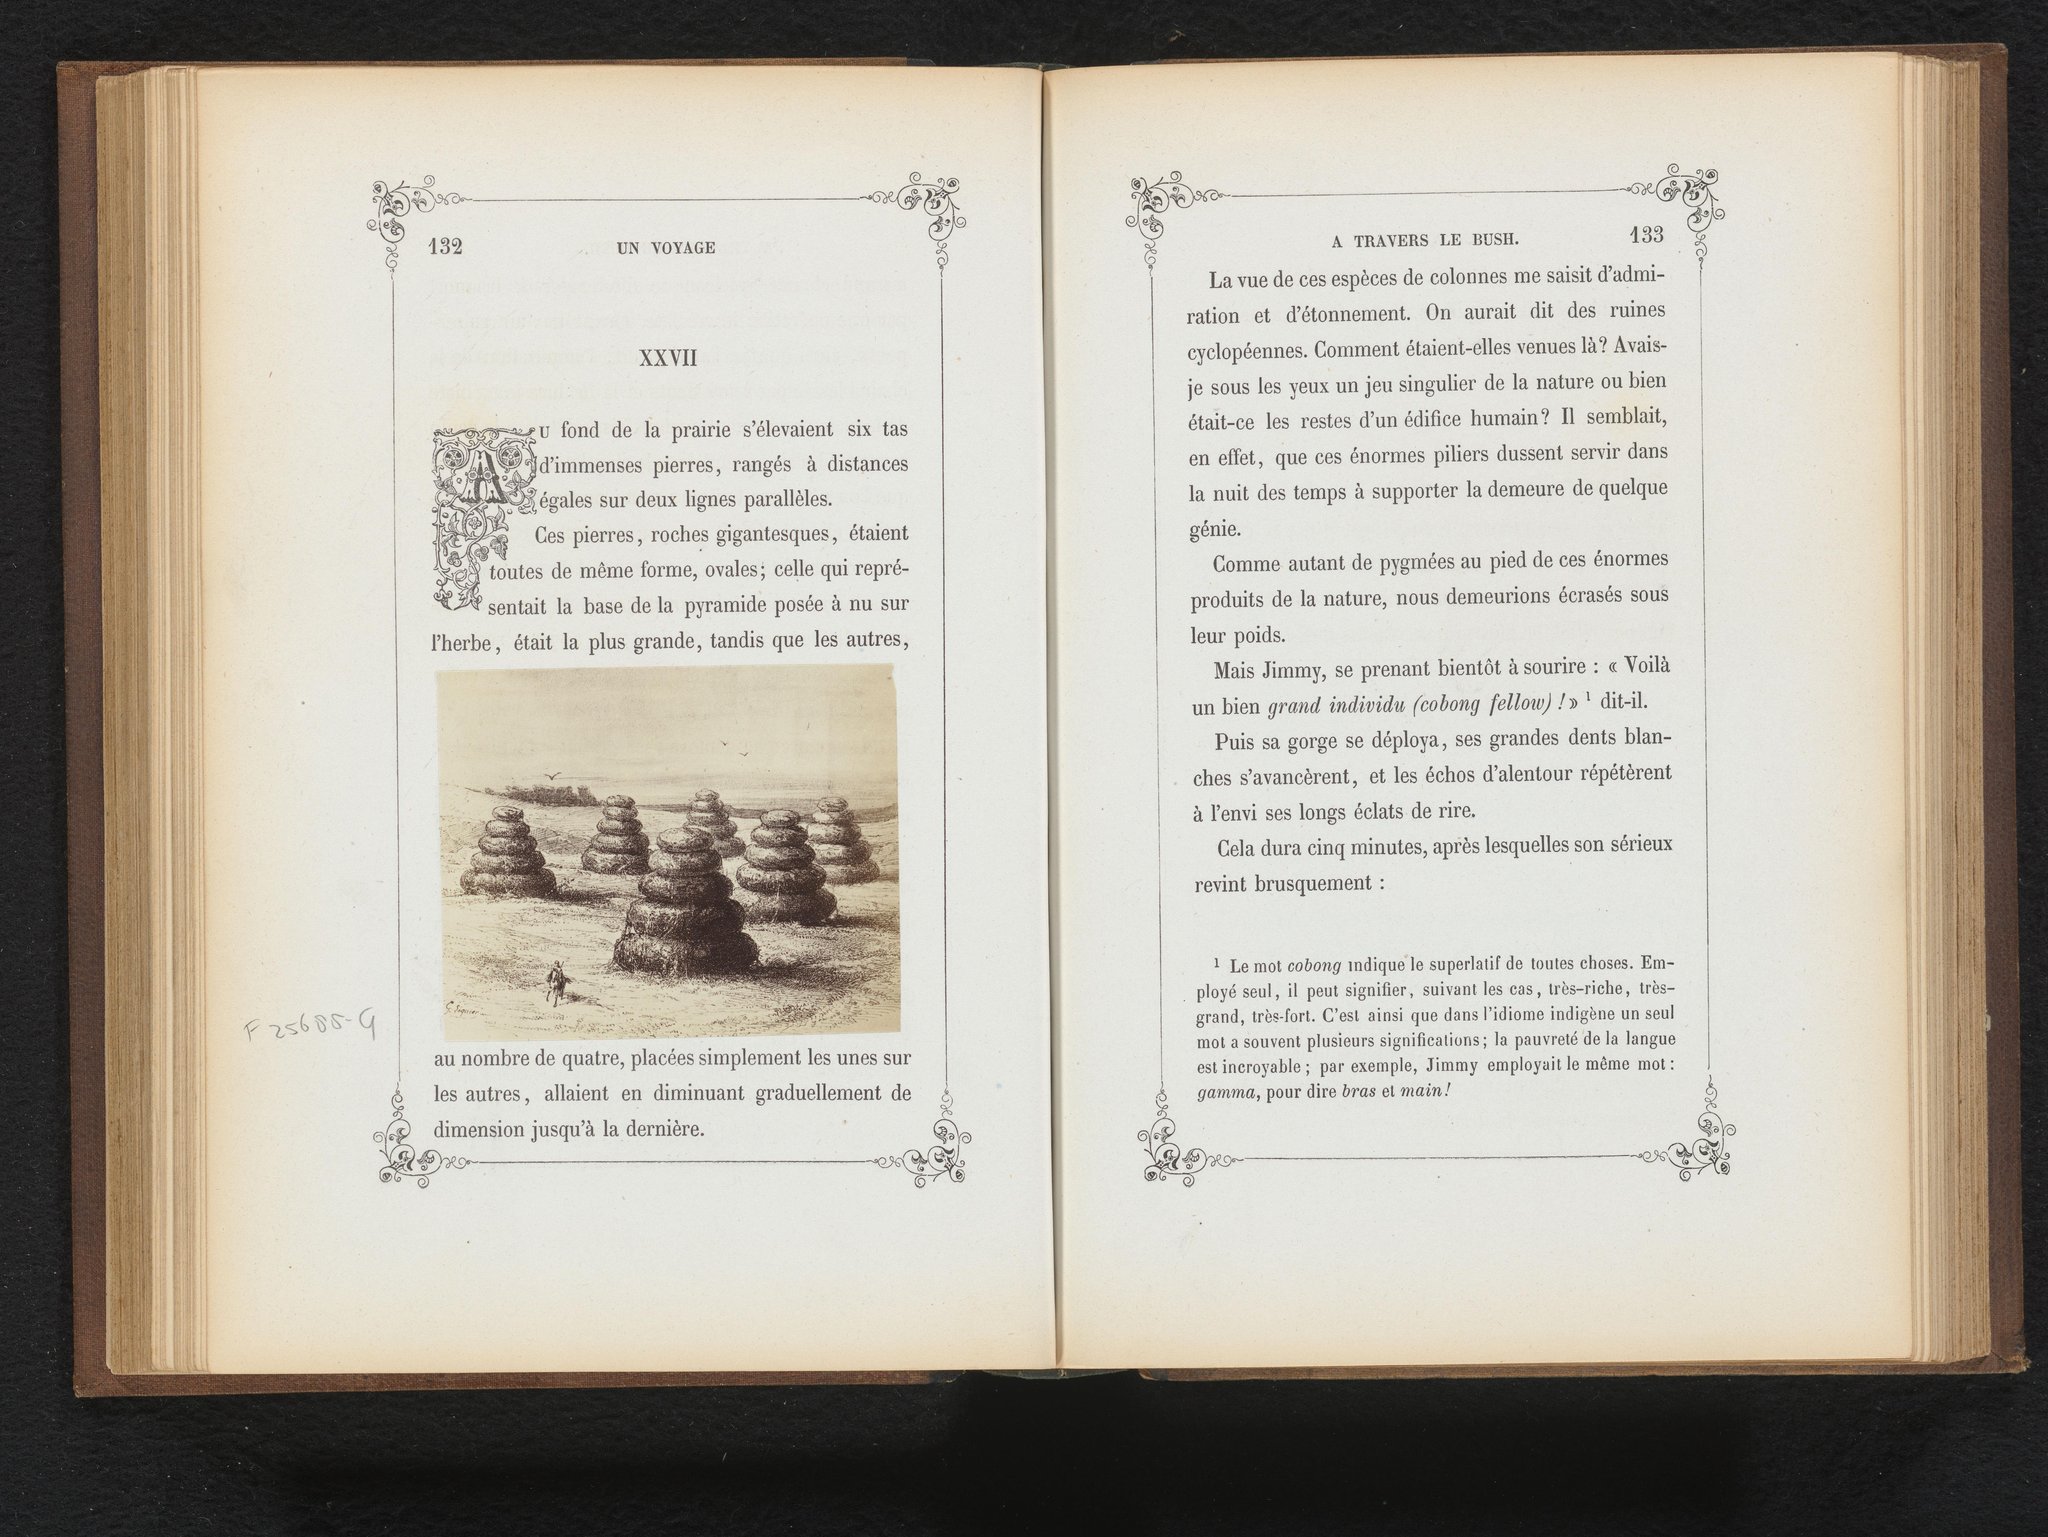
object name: reproduction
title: Fotoreproductie van een tekening van rotsformaties in Australië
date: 1863-1868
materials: paper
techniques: albumen print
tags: rock-formations, australia